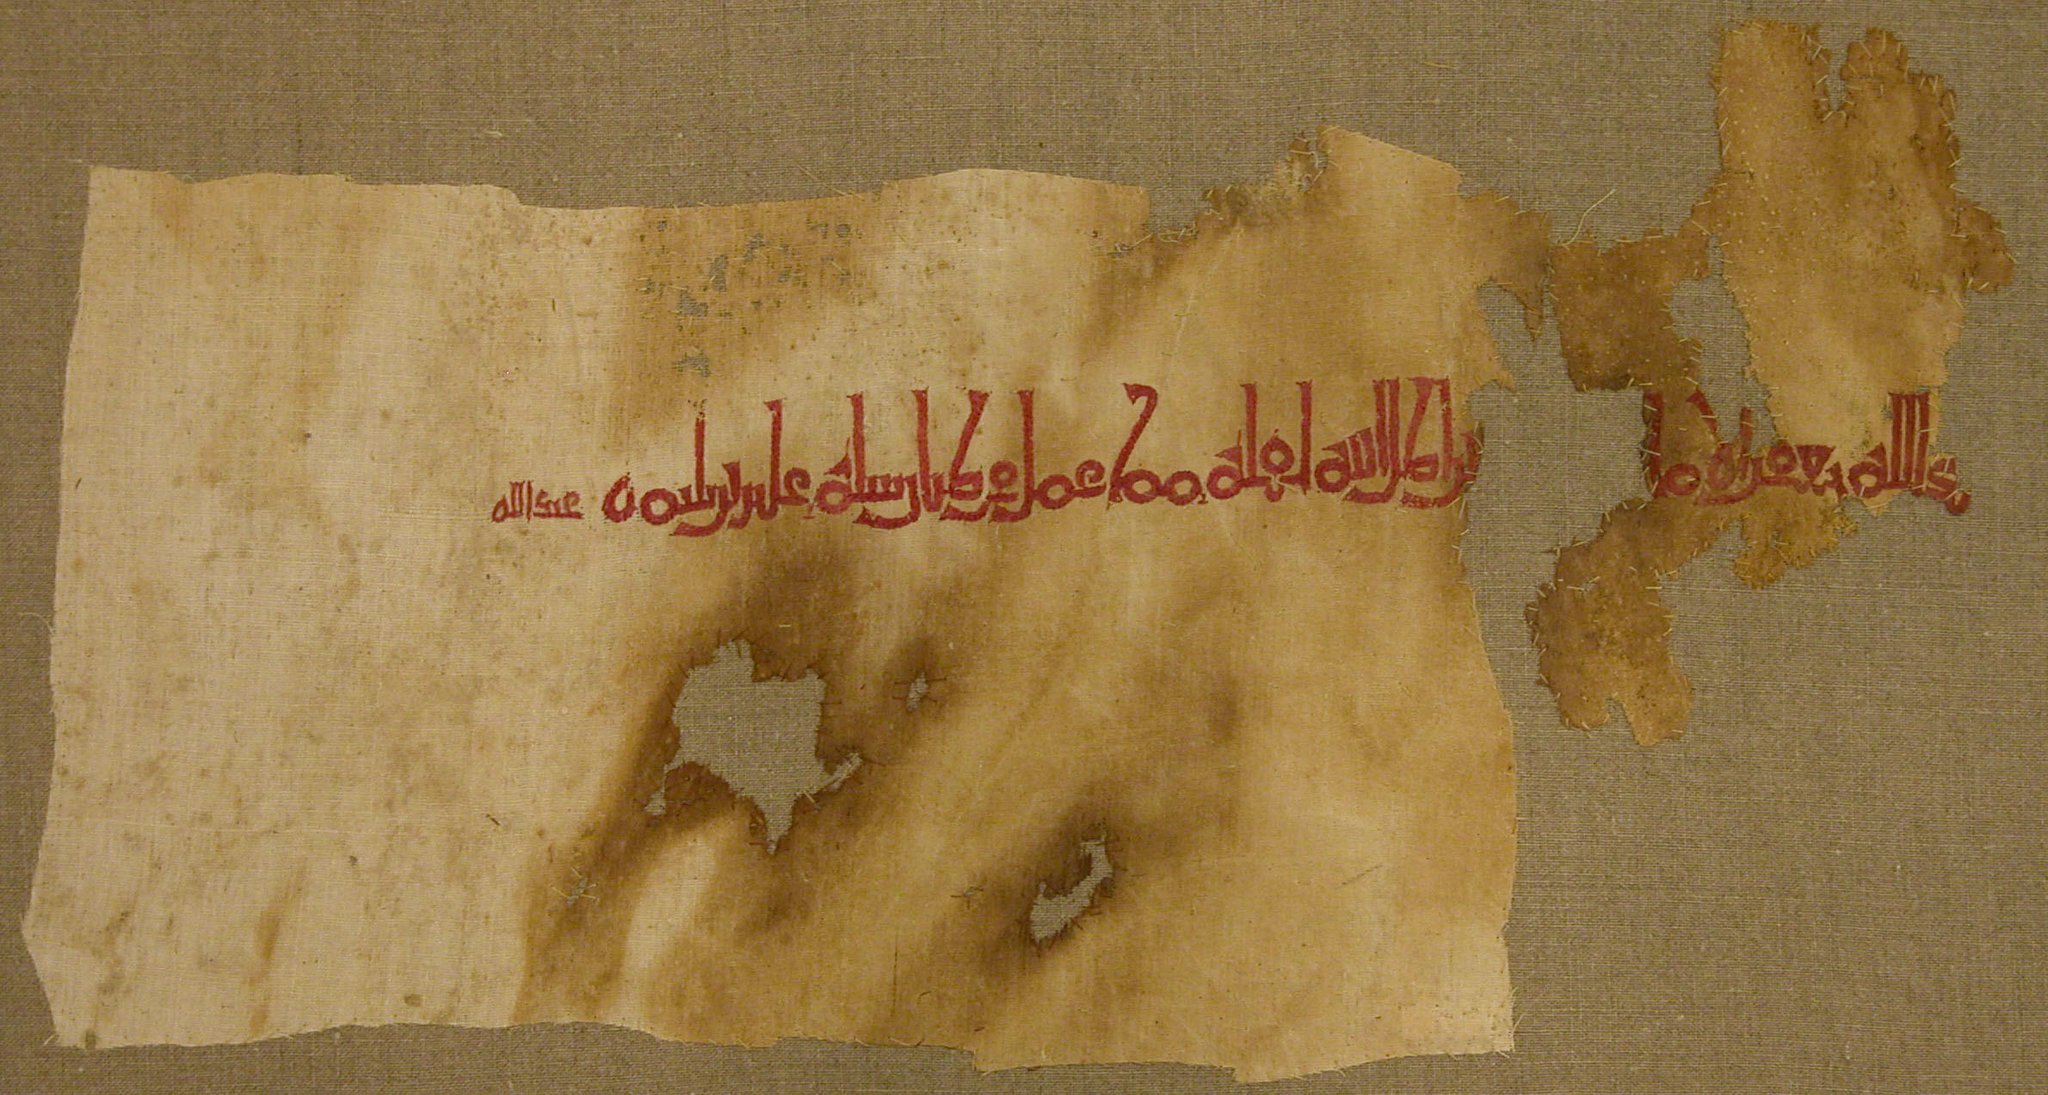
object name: joined textile fragment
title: <Tiraz> Textile Fragments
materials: linen, silk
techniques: embroidery, weave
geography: iraq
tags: arabic